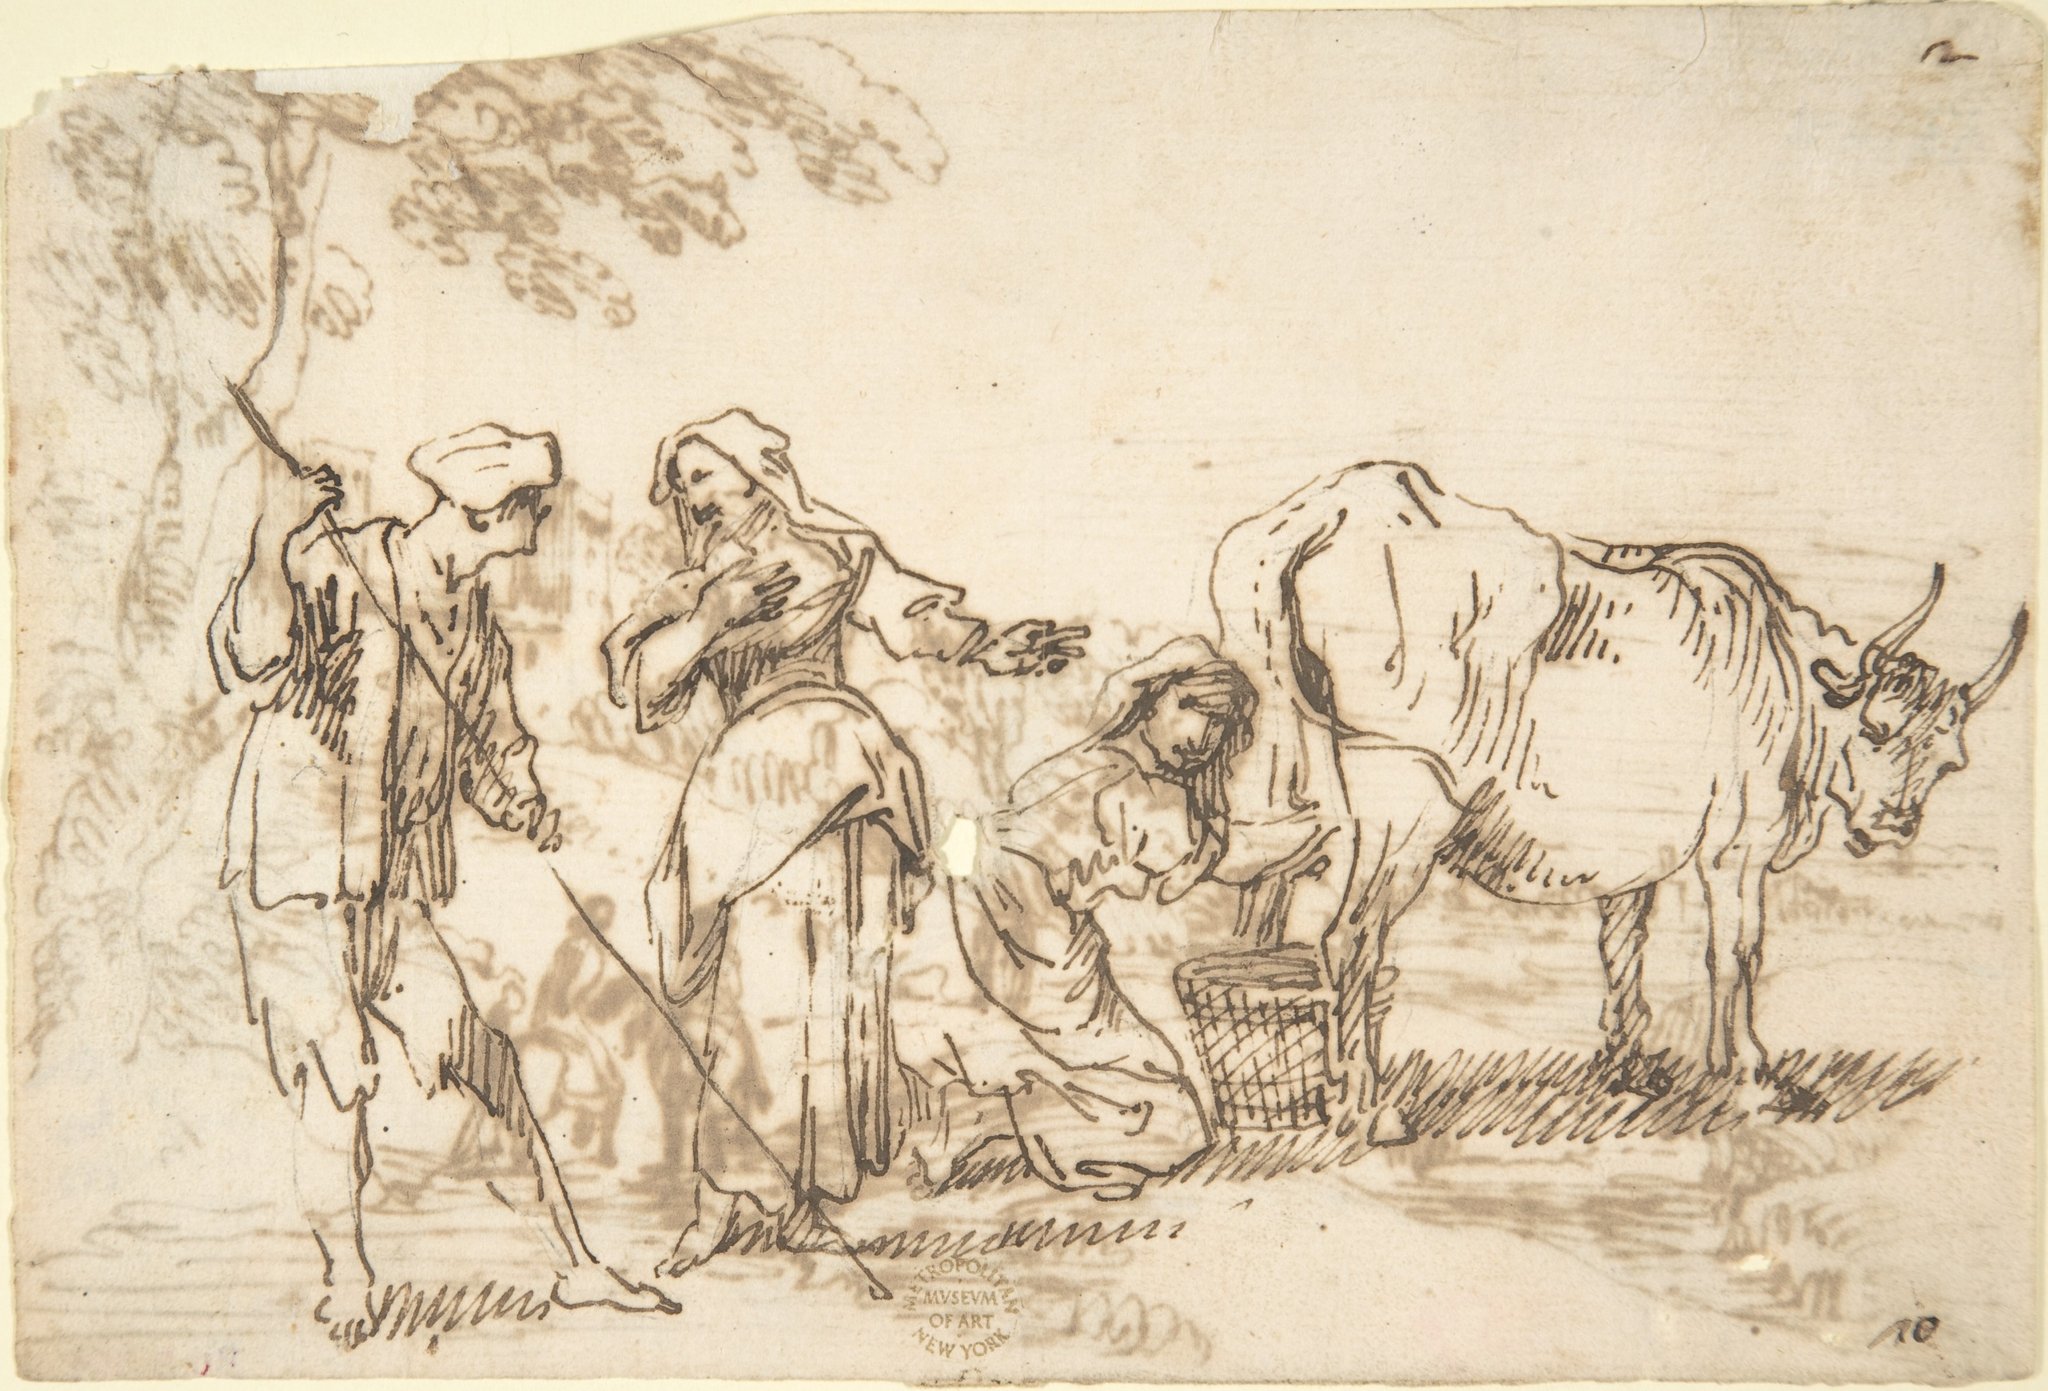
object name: drawing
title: Rustic Scene (recto); Landscape (verso)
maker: anonymous, italian, 17th century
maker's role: artist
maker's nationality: italian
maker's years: 1600-1700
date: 1601-1700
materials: ink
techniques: pen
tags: men,women,bulls,landscapes